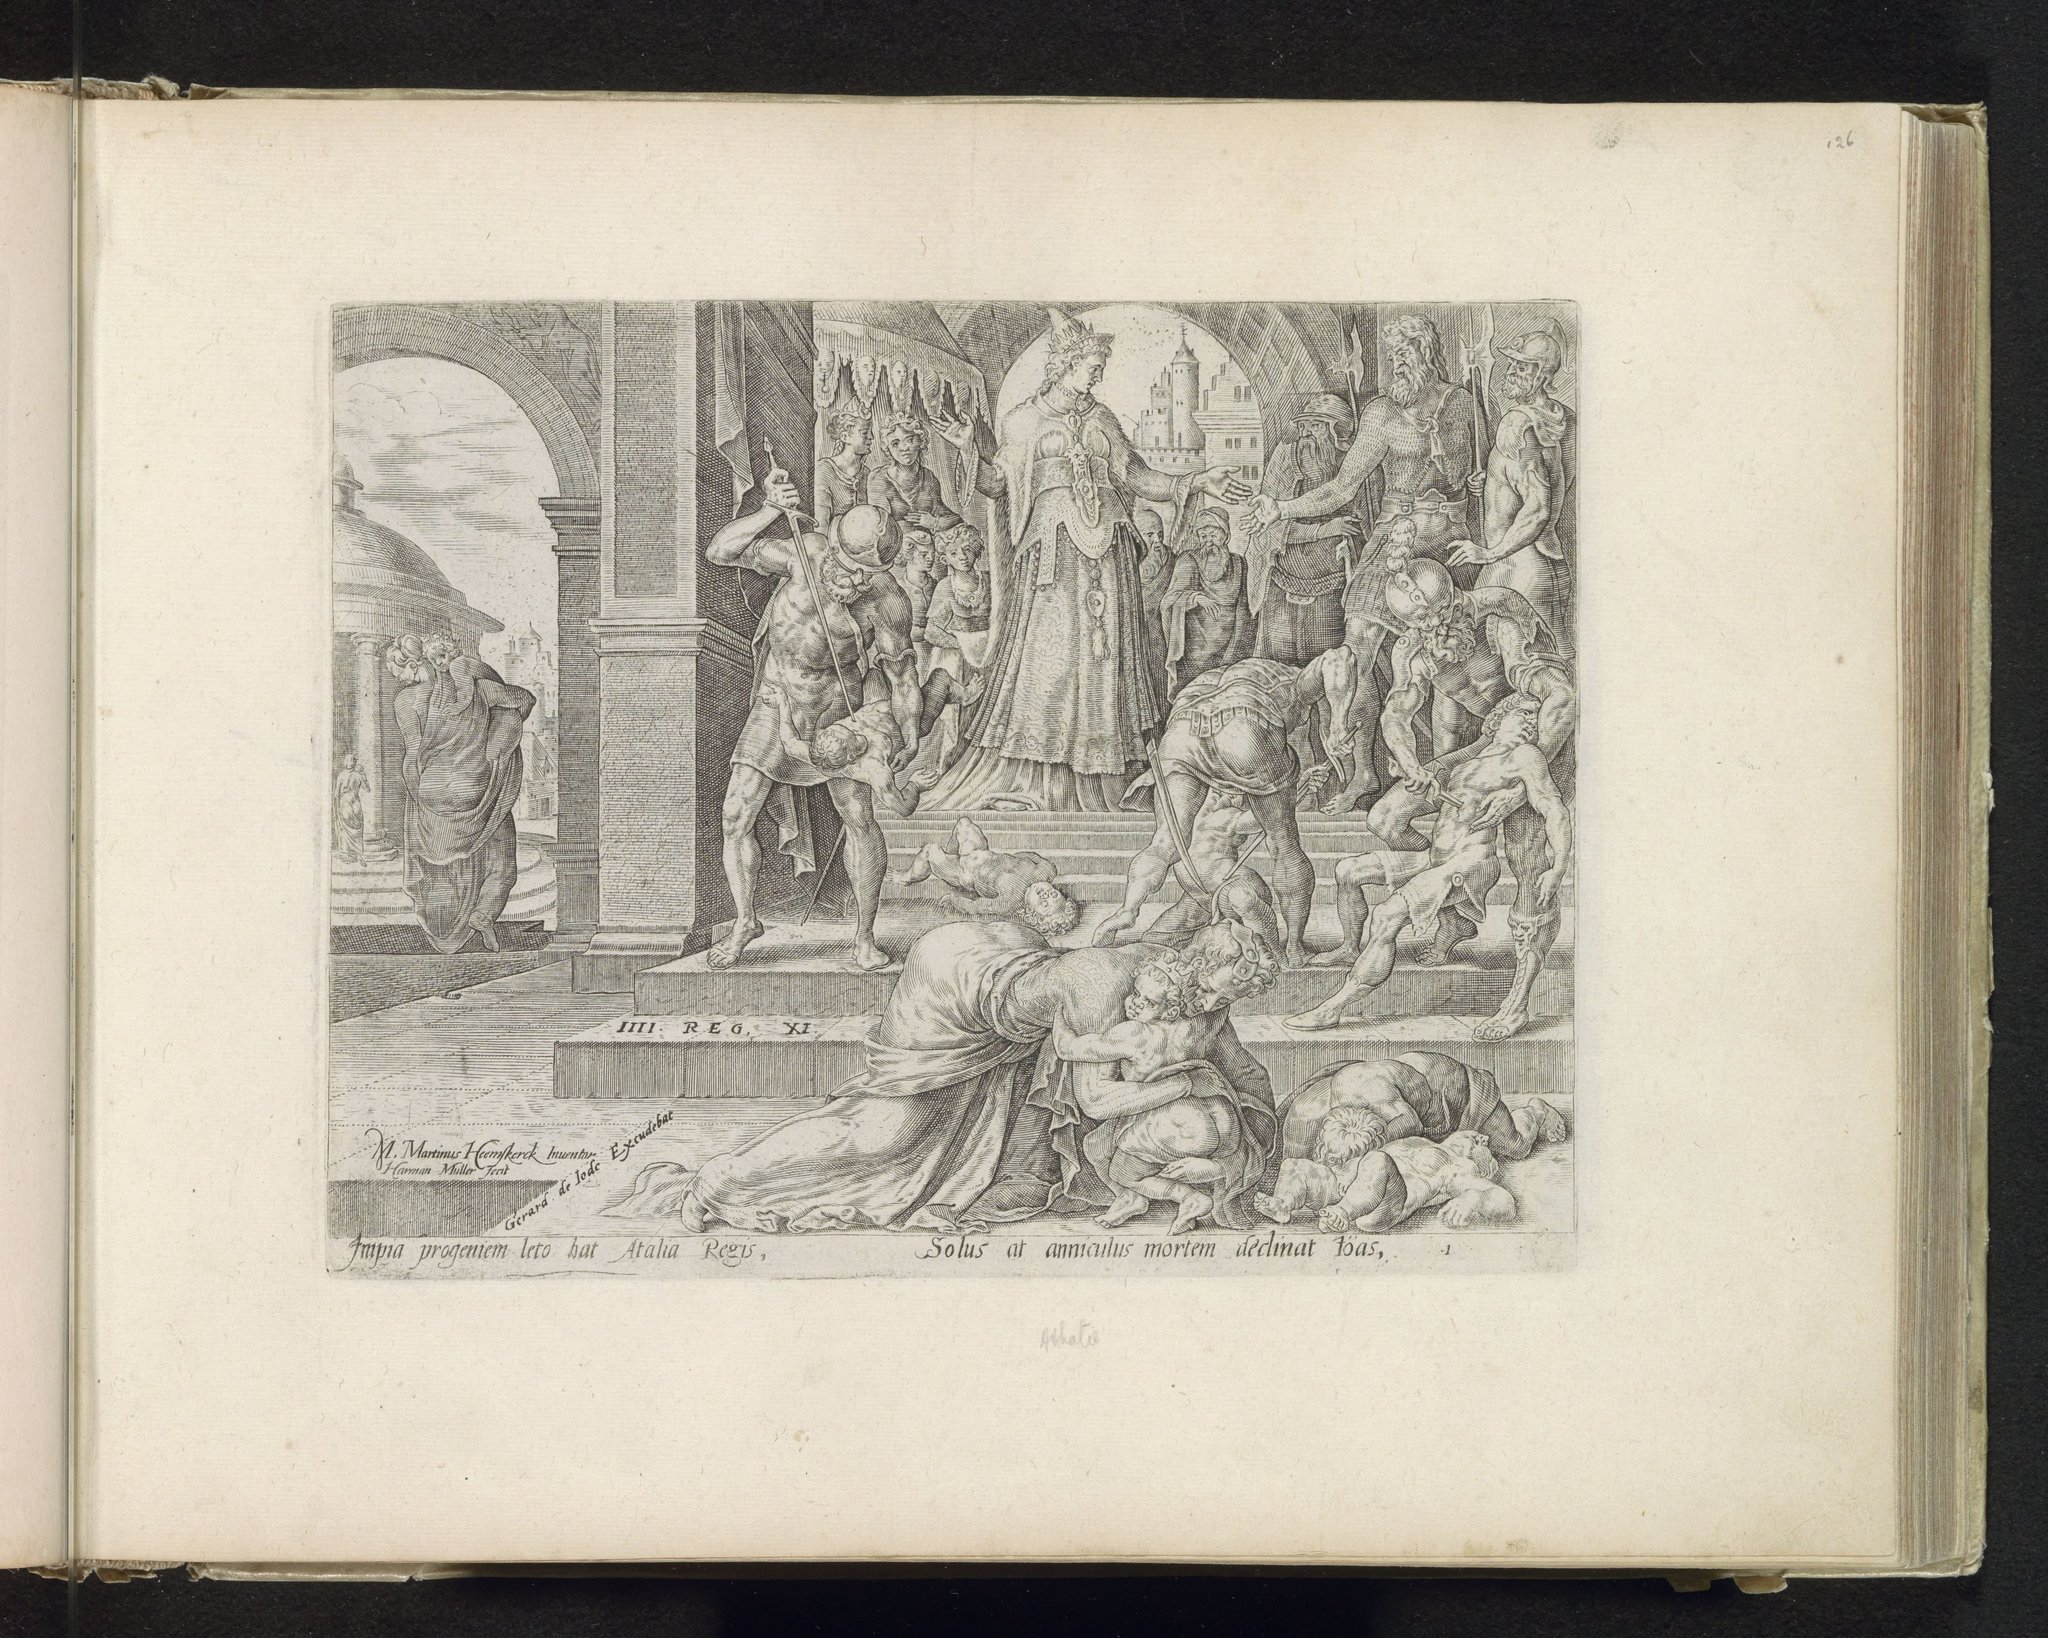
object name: print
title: Koningin Atalja laat de koningskinderen doden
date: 1585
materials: paper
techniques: engraving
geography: antwerp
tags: joash is rescued by his aunt jehosheba, athaliah has all the members of the royal family killed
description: Atalja, die hoorde dat haar zoon koning Achazja was omgekomen, geeft opdracht om alle koningskinderen te doden, zodat zij koningin kan worden. Op de trap doden soldaten de kinderen. Links wordt Achazja's zoon Joas door zijn tante gered. Op de trap een verwijzing naar de Bijbeltekst in 2 Kon. 11. Onderaan in de marge een vers in het Latijn over de voorstelling. Deze prent maakt deel uit van een album.